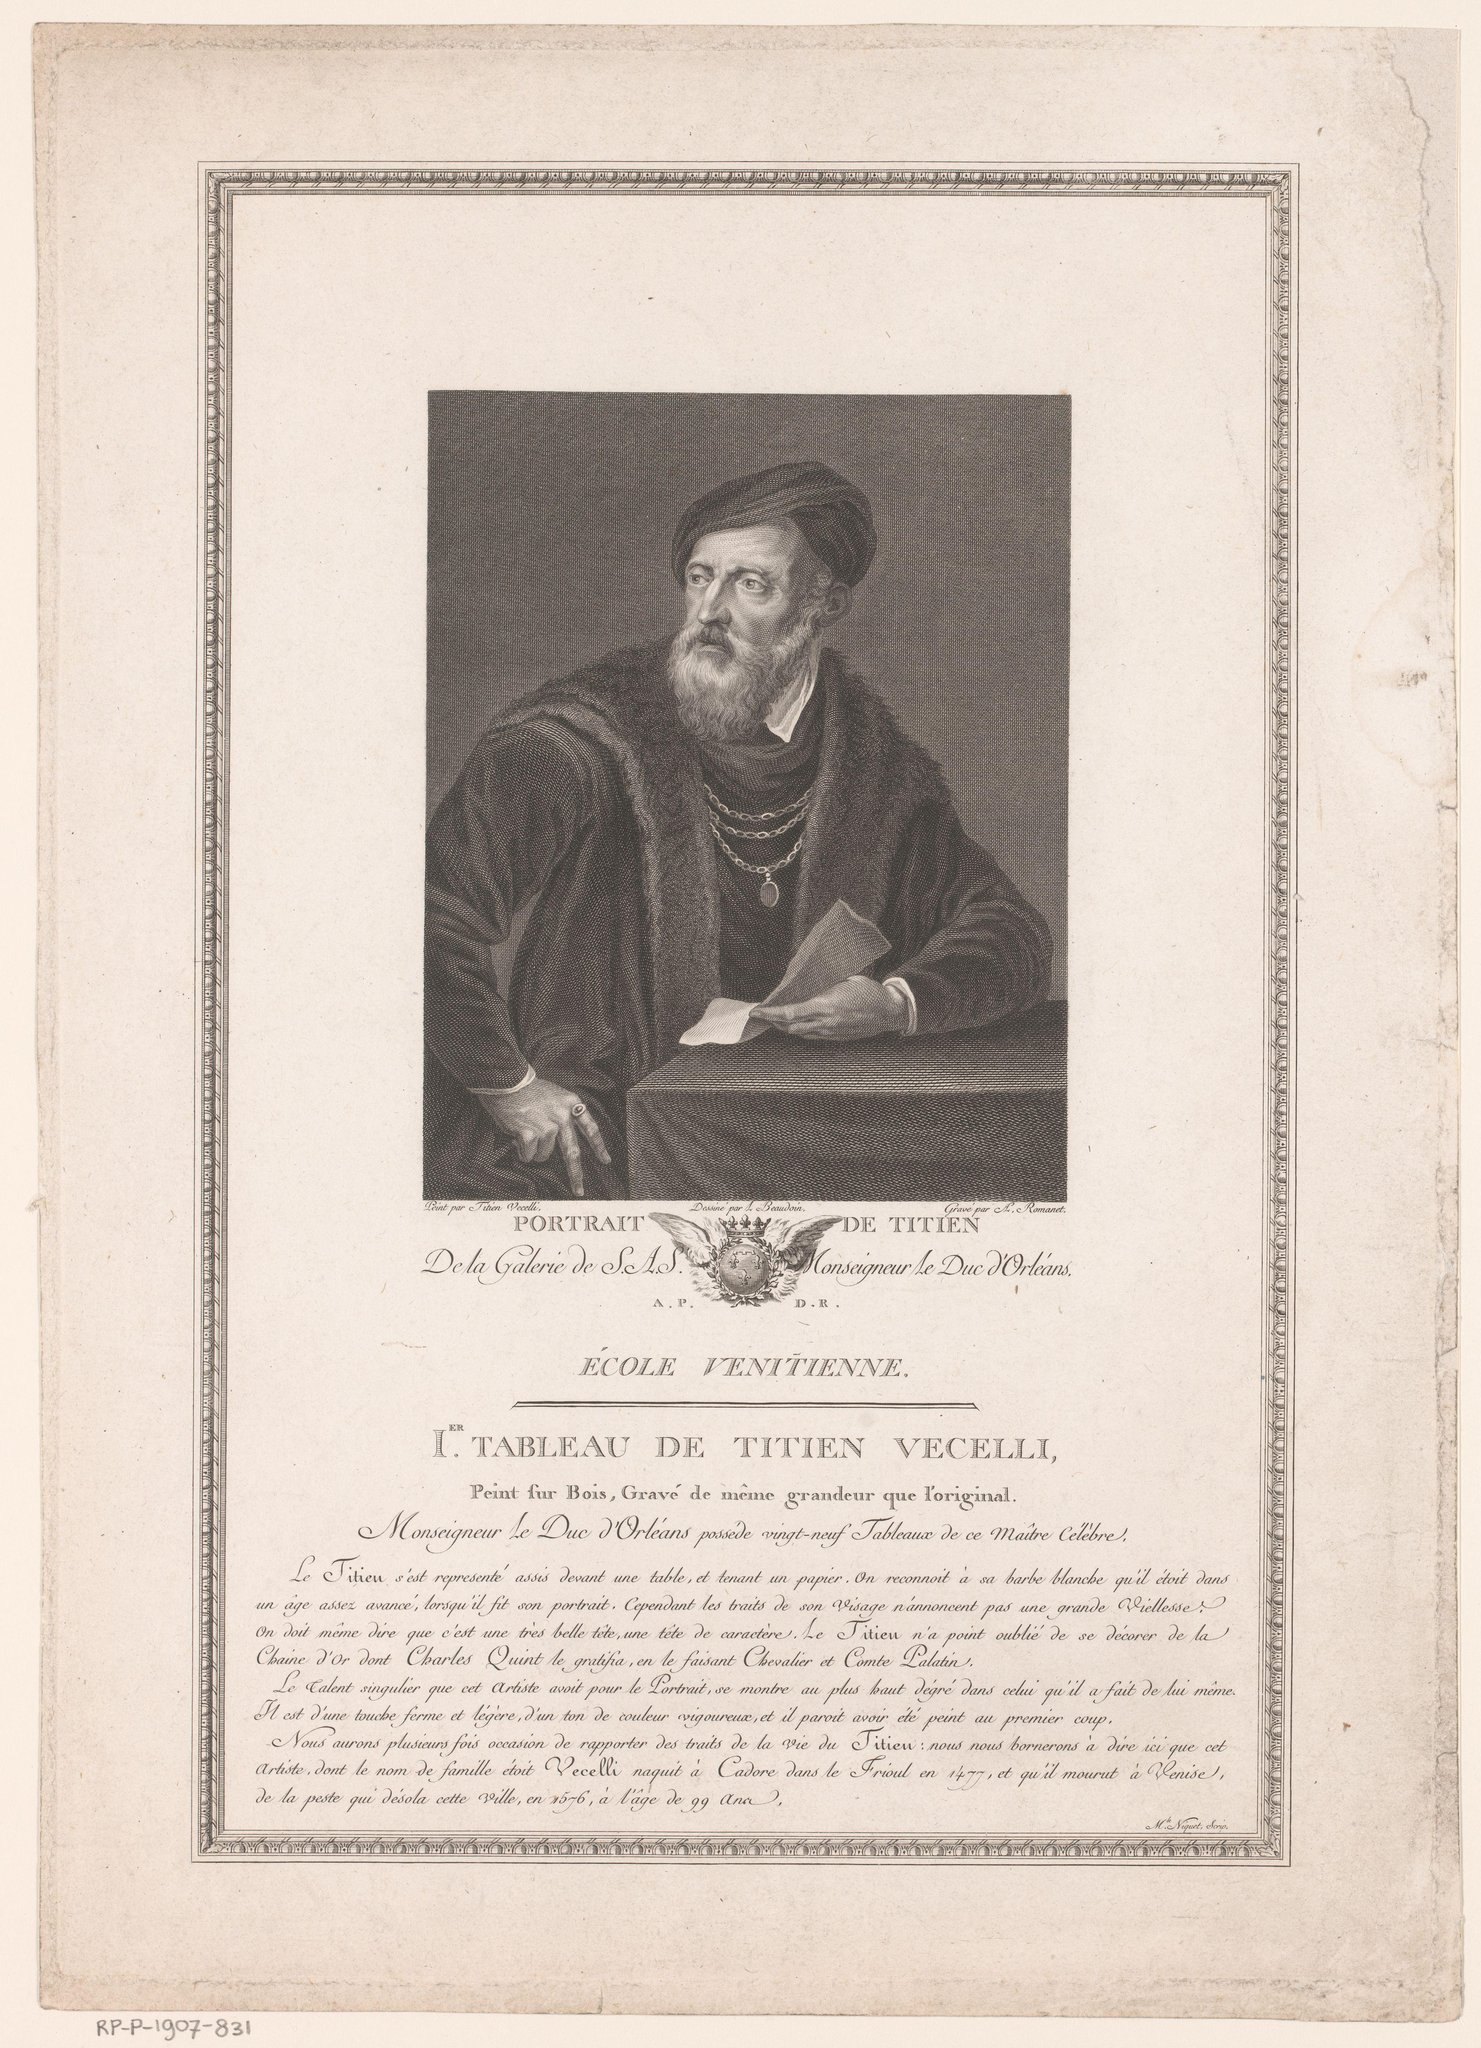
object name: print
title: La Galerie du Palais Royal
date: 1786-1808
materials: paper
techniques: engraving, etching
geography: paris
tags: venice, painter, draughtsman, titiaan, historical persons, portrait, self-portrait of painter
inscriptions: collector's mark: Lugt 2228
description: Onderdeel van een serie van 354 prenten naar schilderijen uit de collectie van de Hertog van Orléans, getiteld: La Galerie du Palais Royal, uitgebracht tussen 1786 en 1808. De serie werd uitgegeven door Jacques Couché die het project samen met Jacques Bouillard leidde.